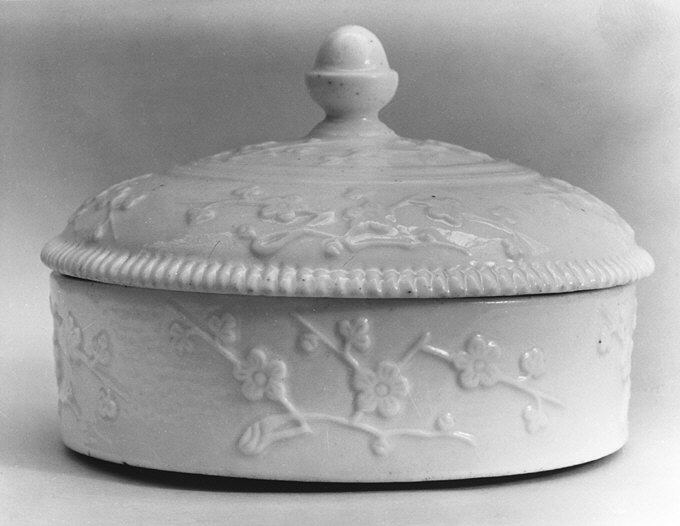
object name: box with cover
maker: saint-cloud factory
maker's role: factory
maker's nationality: french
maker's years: 1693-1766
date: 1720-1740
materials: soft paste porcelain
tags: flowers